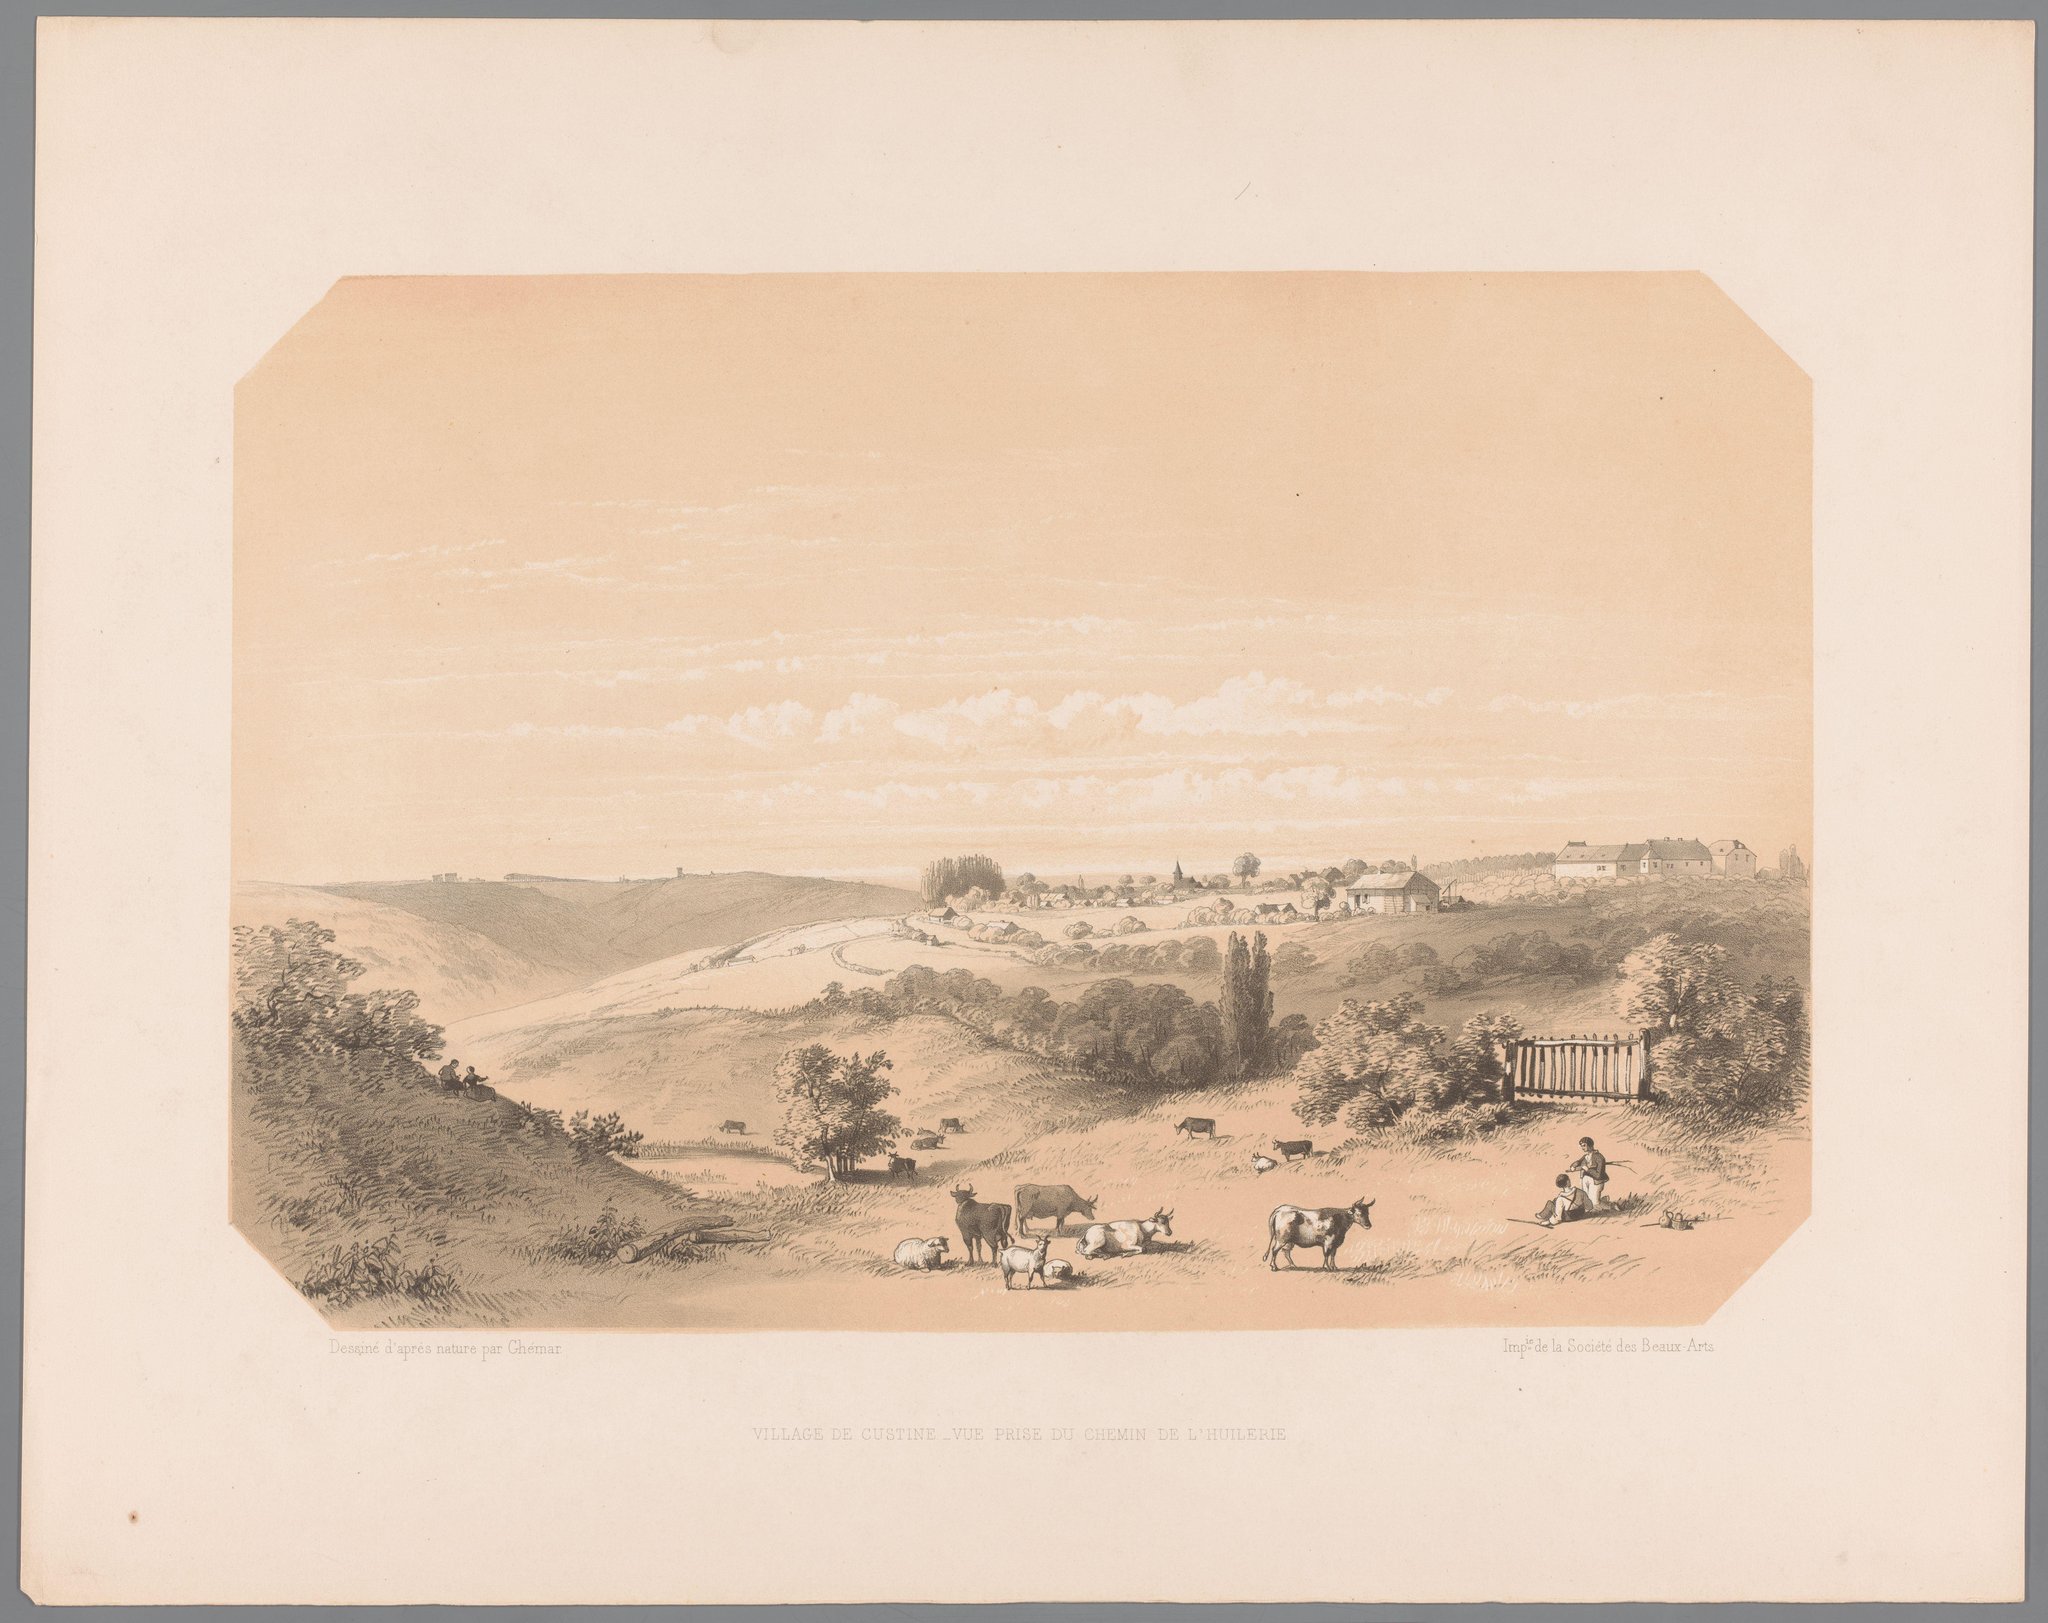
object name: print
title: Gezicht op Custinne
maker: louis ghémar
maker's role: draughtsman, print maker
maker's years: 1819-1873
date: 1846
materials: paper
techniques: tone lithography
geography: brussels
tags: herding, herdsman, herdswoman, shepherd, shepherdess, cowherd, etc., low hill country (+ landscape with figures, staffage), village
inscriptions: collector's mark: Lugt 2228